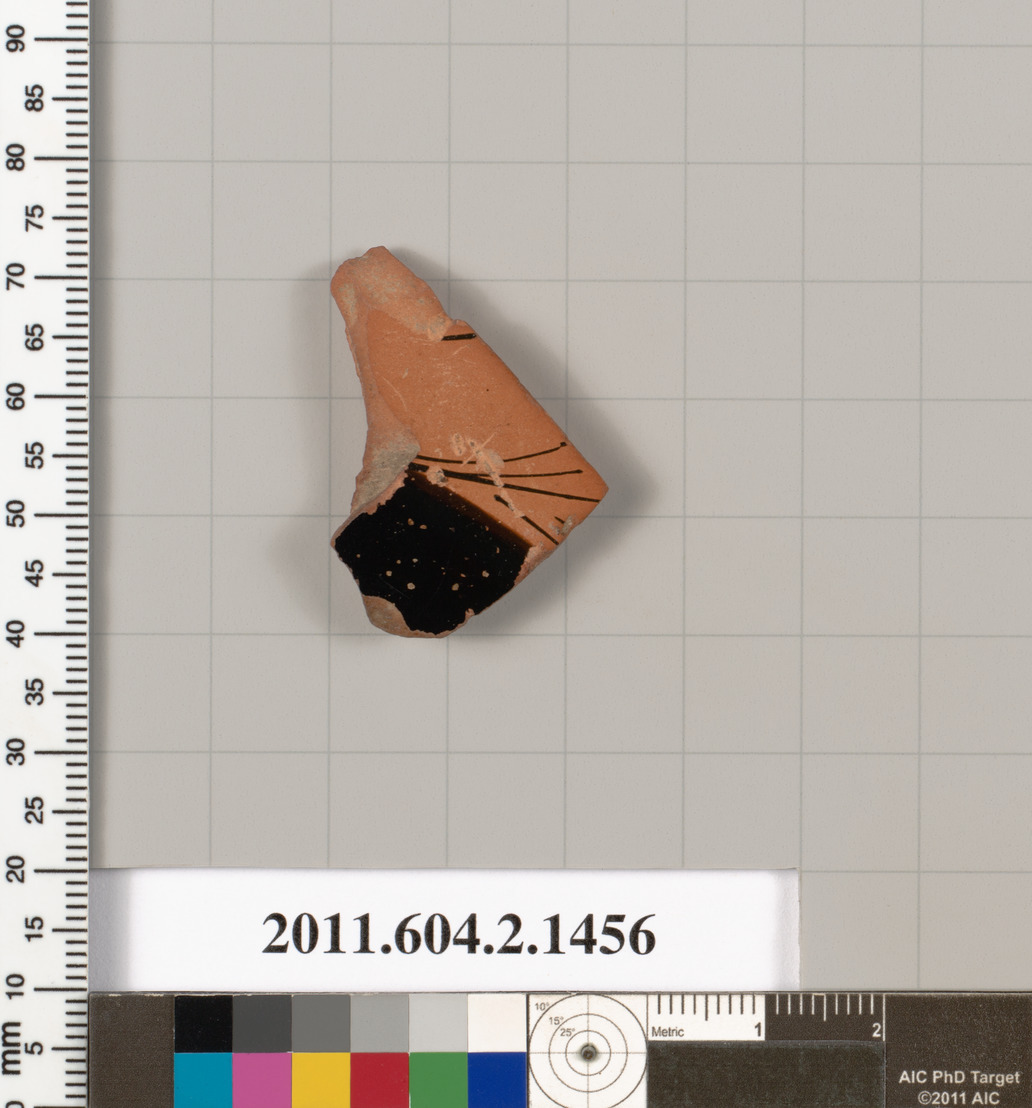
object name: skyphos fragment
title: Terracotta fragment of a skyphos (deep drinking cup)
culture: greek, attic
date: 460-440 BCE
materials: terracotta